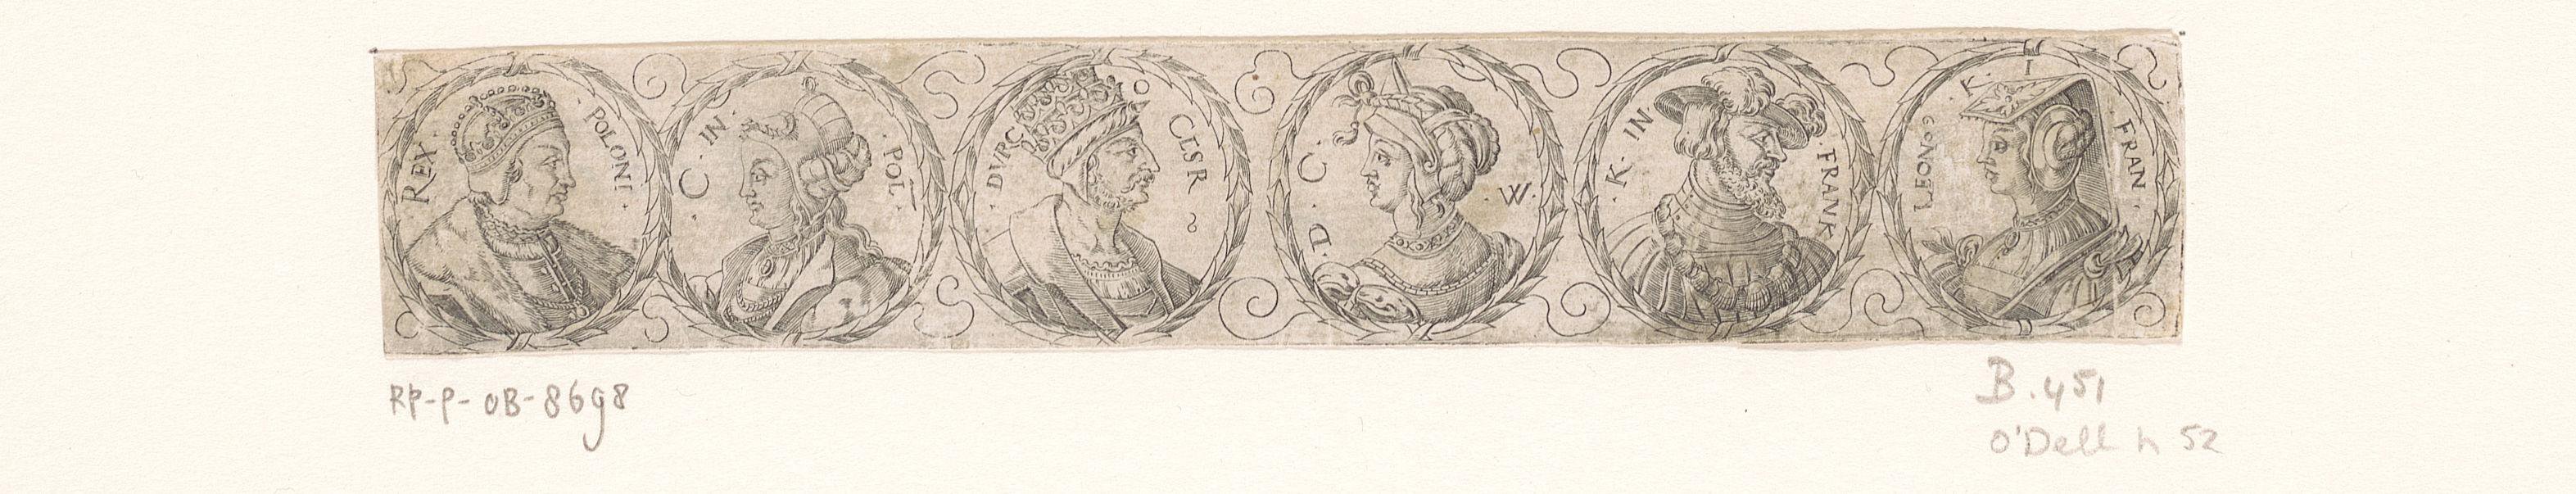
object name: print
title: Fries met zes bustes in lauwerkransen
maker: virgilius solis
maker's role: draughtsman, print maker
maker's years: 1514-1562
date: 1524-1562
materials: paper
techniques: engraving, intaglio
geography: nuremberg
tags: chest, bust, head-gear, ornament ~ medallion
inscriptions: collector's mark: Lugt 2228, number: ‘15’